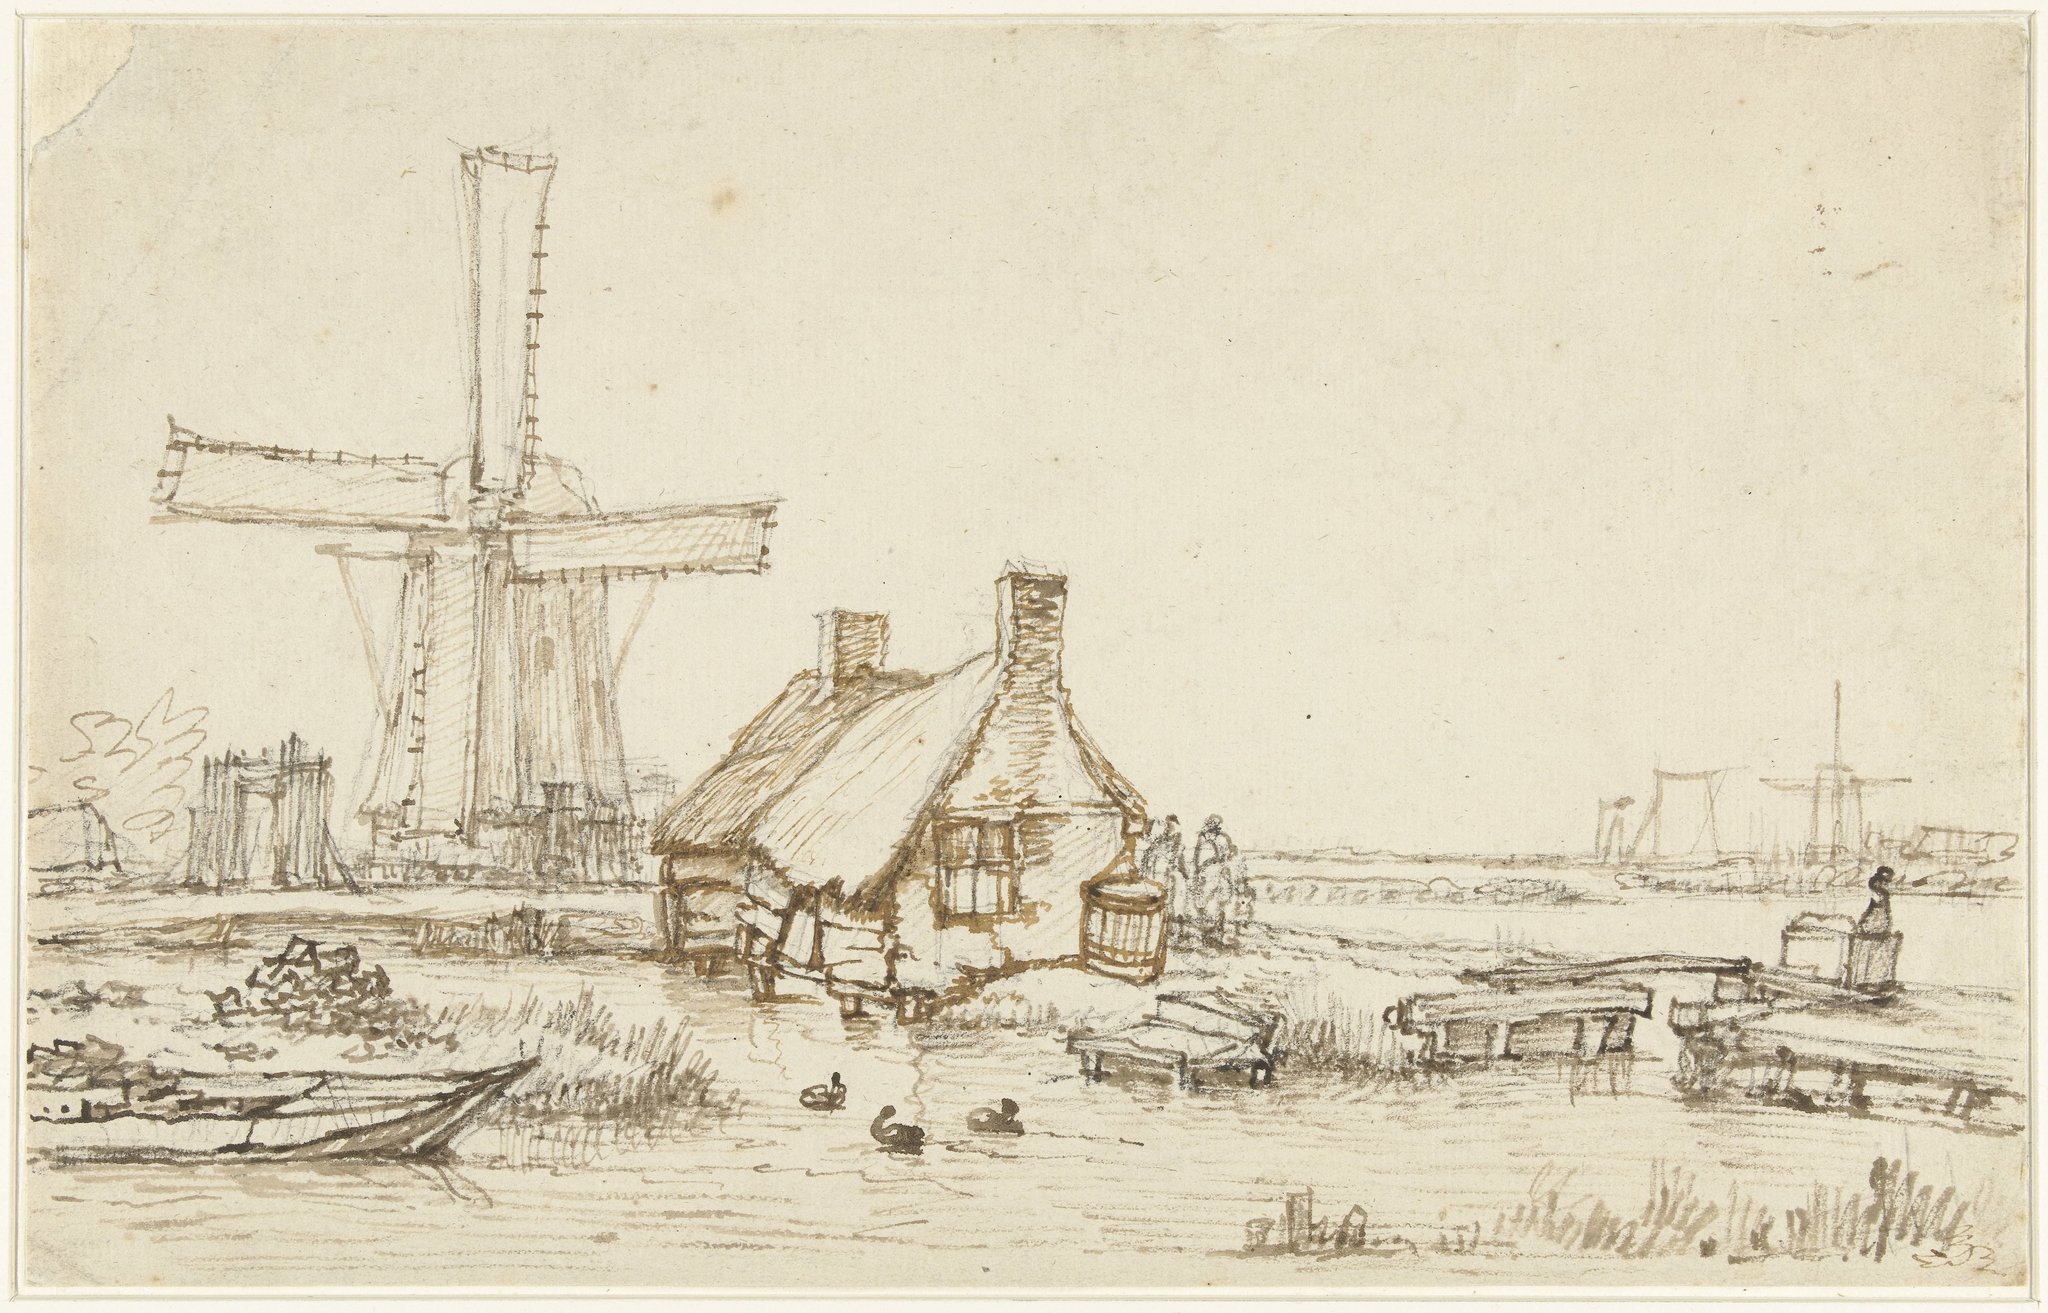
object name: drawing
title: Landschap met huisjes en windmolen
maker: jan hulswit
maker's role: draughtsman, painter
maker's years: 1766-1822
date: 1776-1822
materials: chalk, ink, paper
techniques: pen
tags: windmill